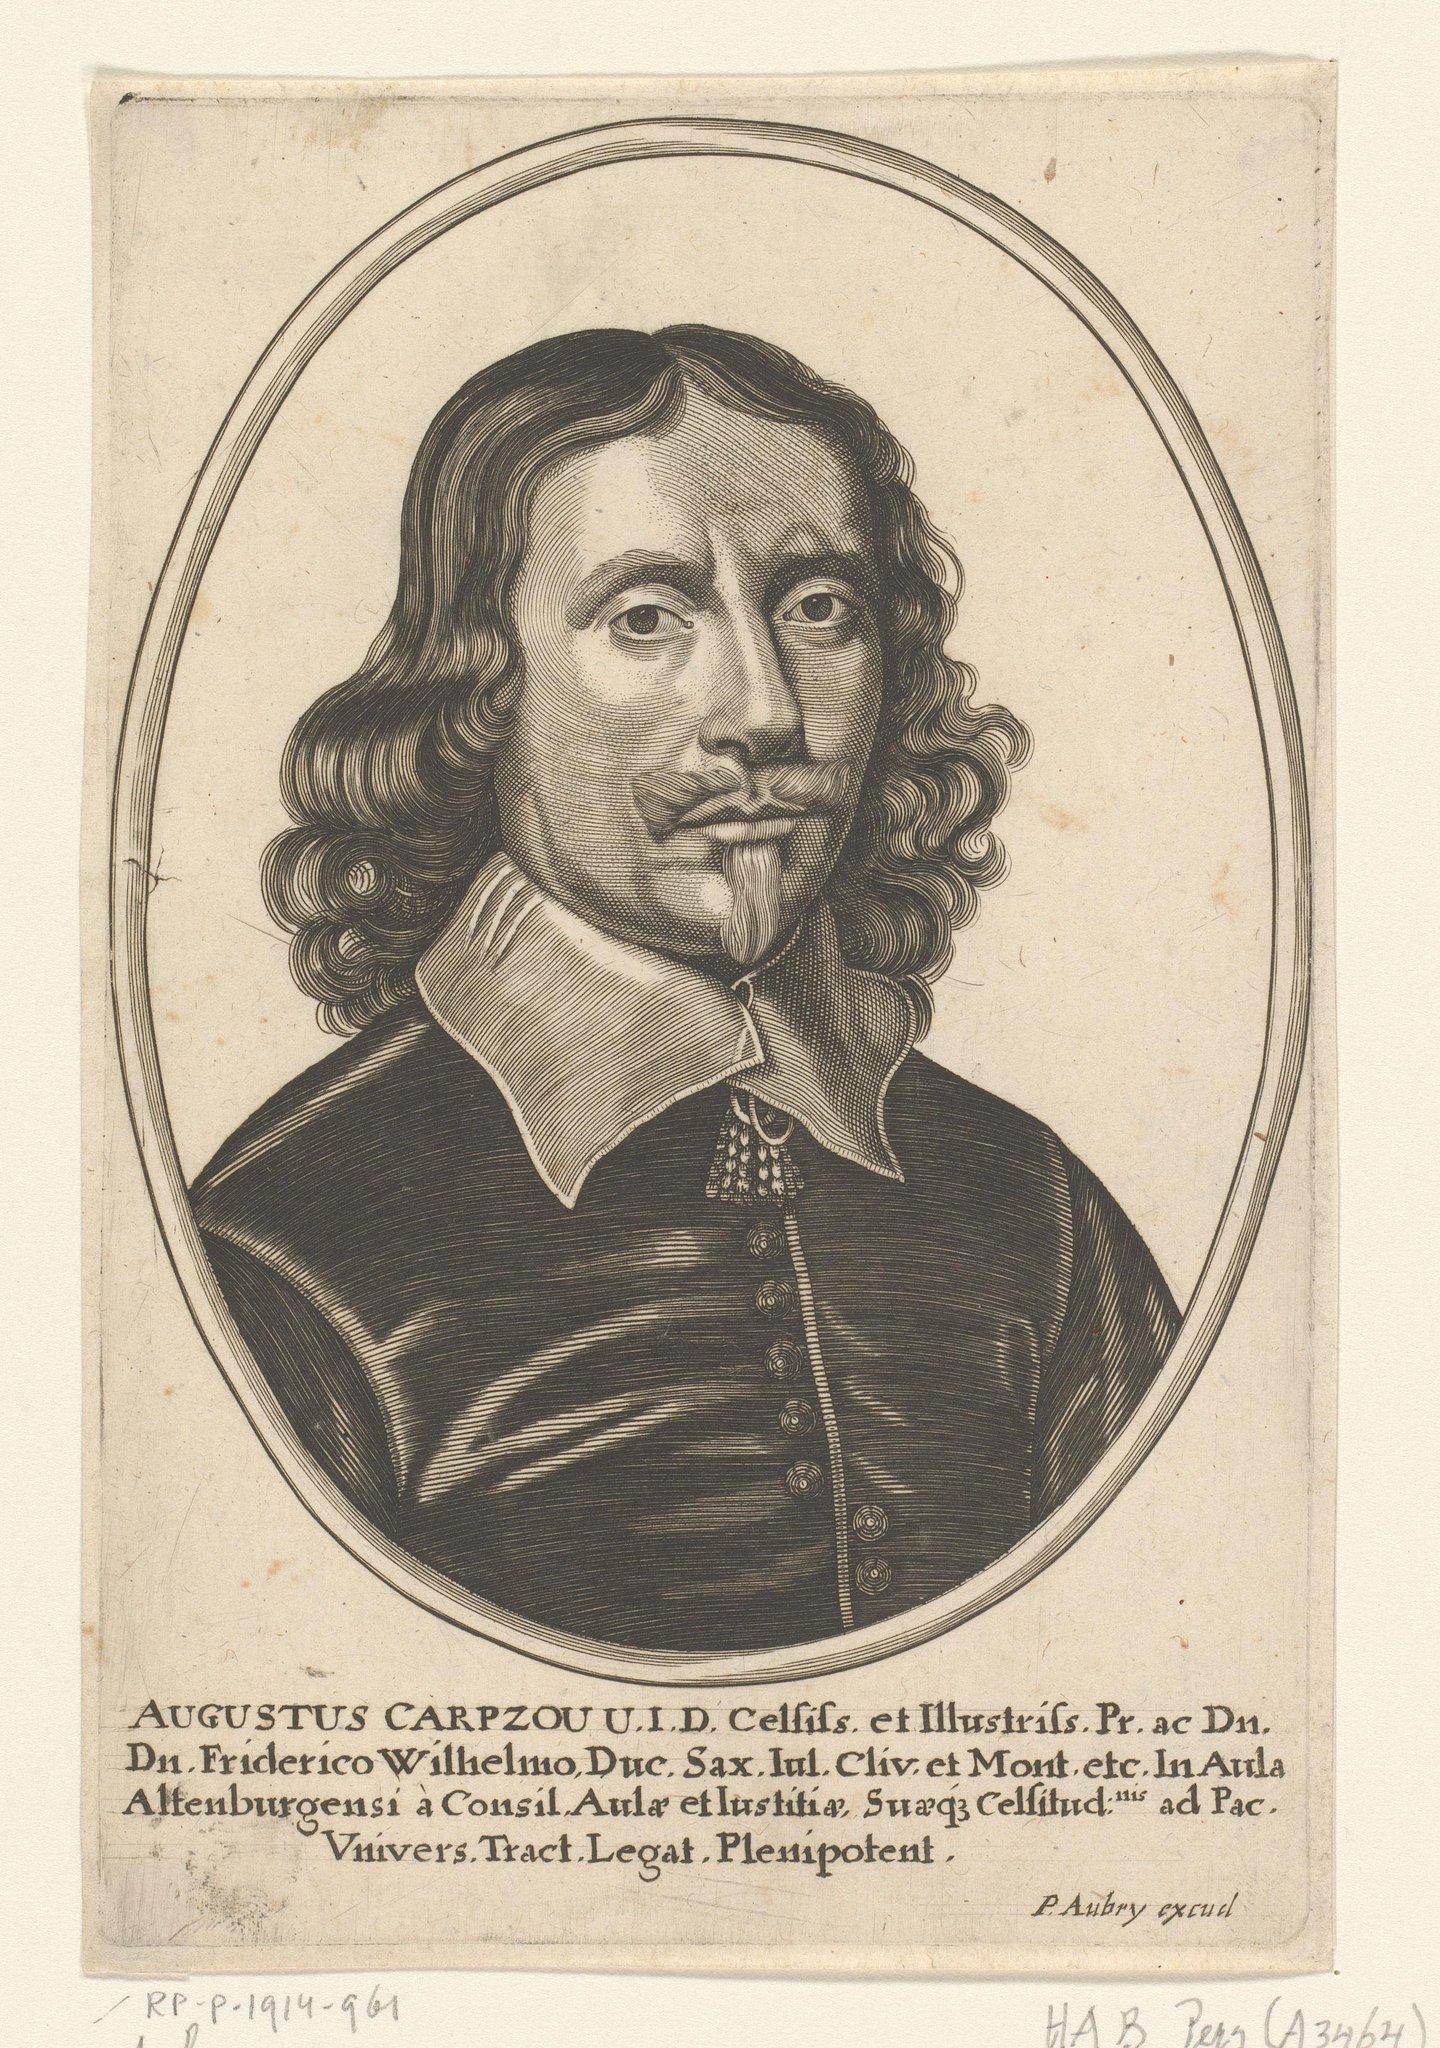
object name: print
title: Portret van Augustus Carpzou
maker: Anonymous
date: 1648-1650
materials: paper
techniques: engraving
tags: historical persons, lawyer, attorney at law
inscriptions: collector's mark: Lugt 2228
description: Met vierregelig onderschrift in het Latijn.